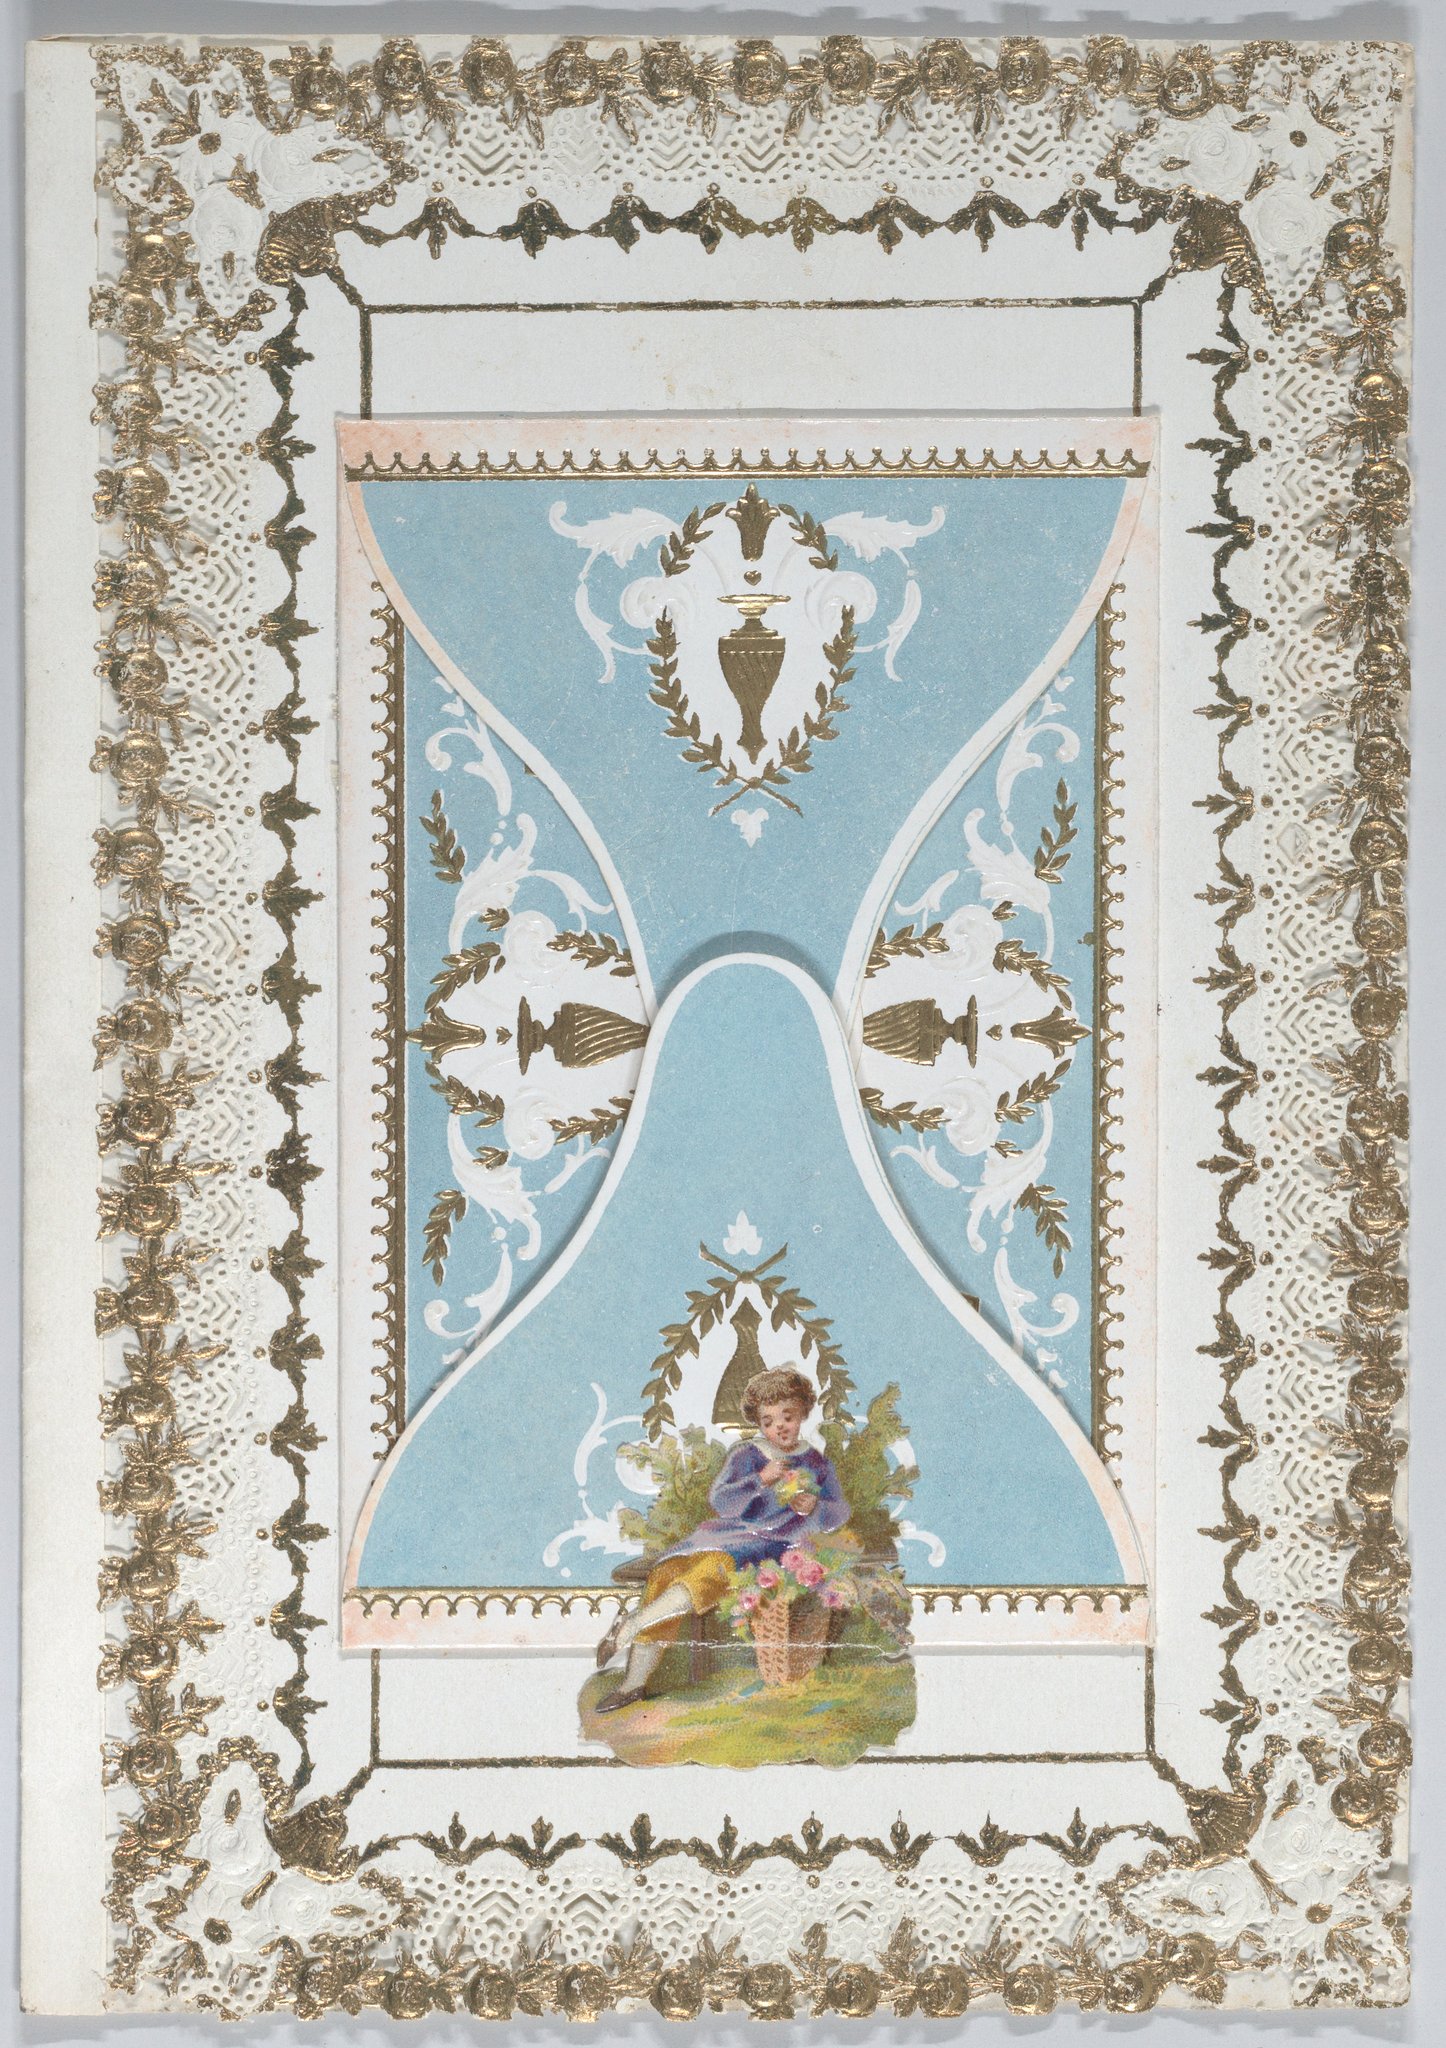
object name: valentine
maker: Anonymous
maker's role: artist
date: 1850-1860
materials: ink, paper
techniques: chromolithography, embossing, gilding, open work